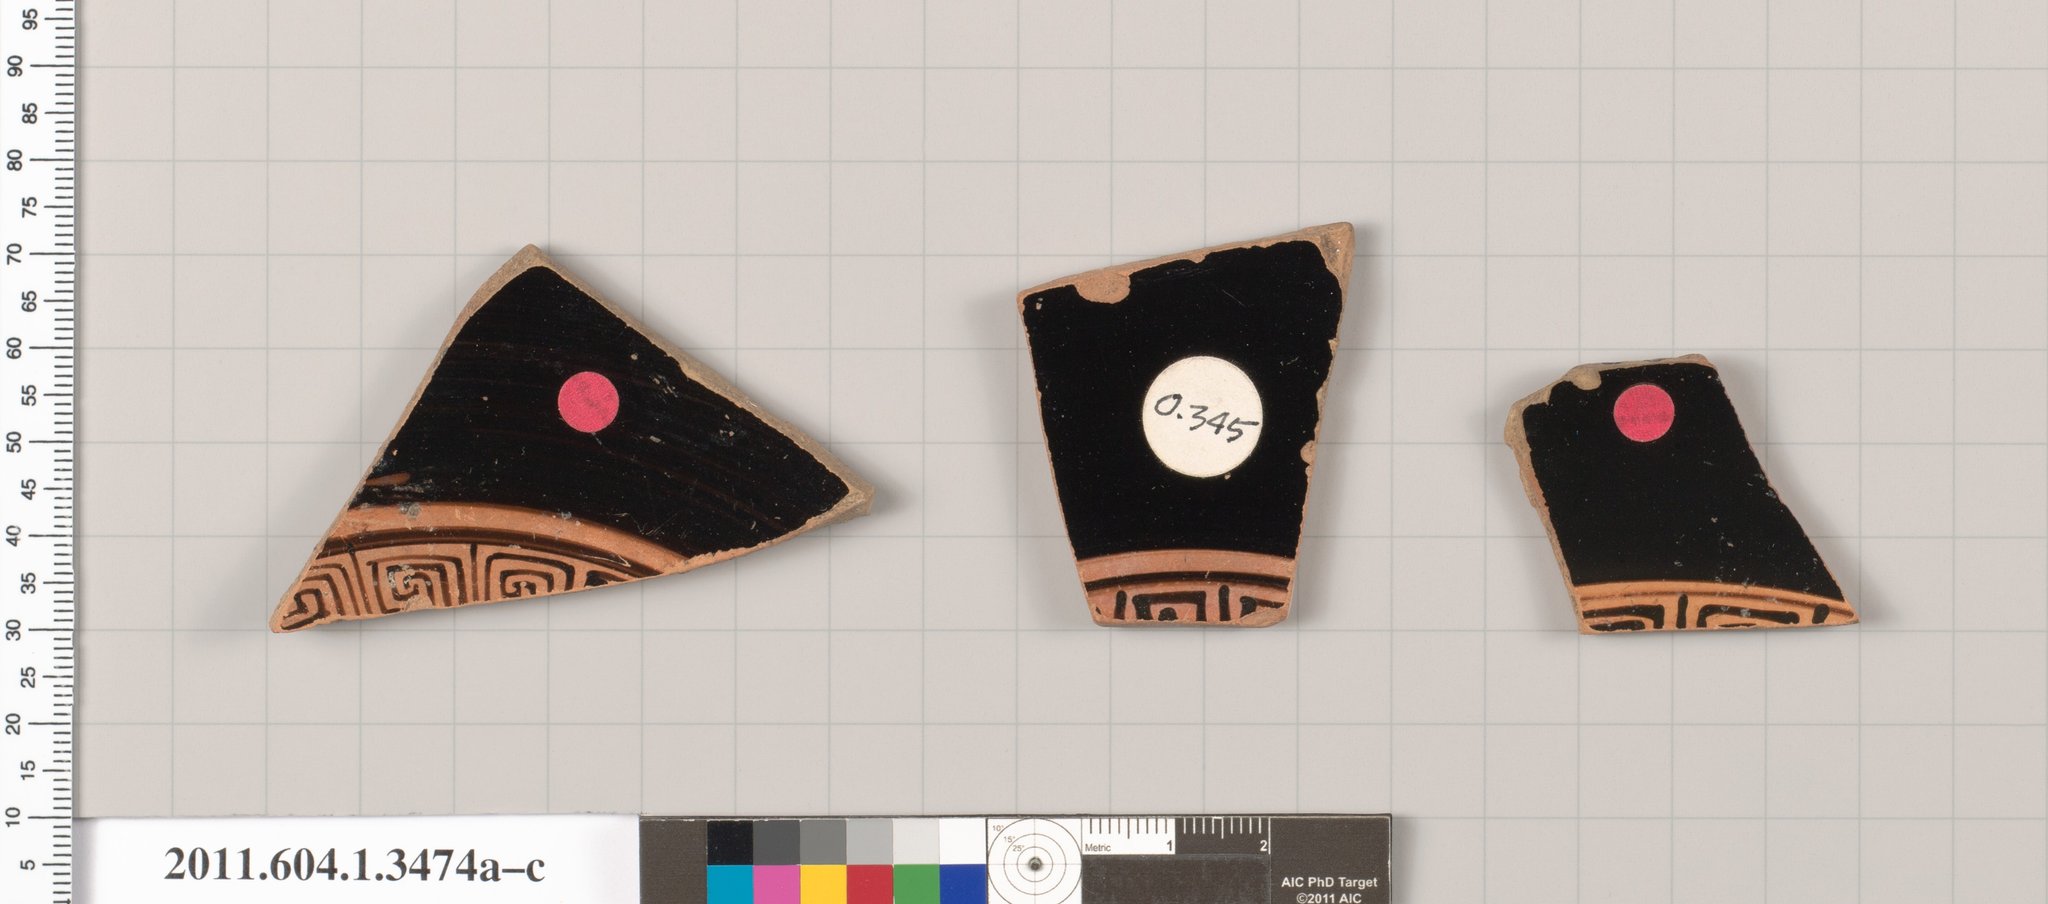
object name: kylix fragment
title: Terracotta fragments of kylikes (drinking cups)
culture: greek, attic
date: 500-475 BCE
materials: terracotta